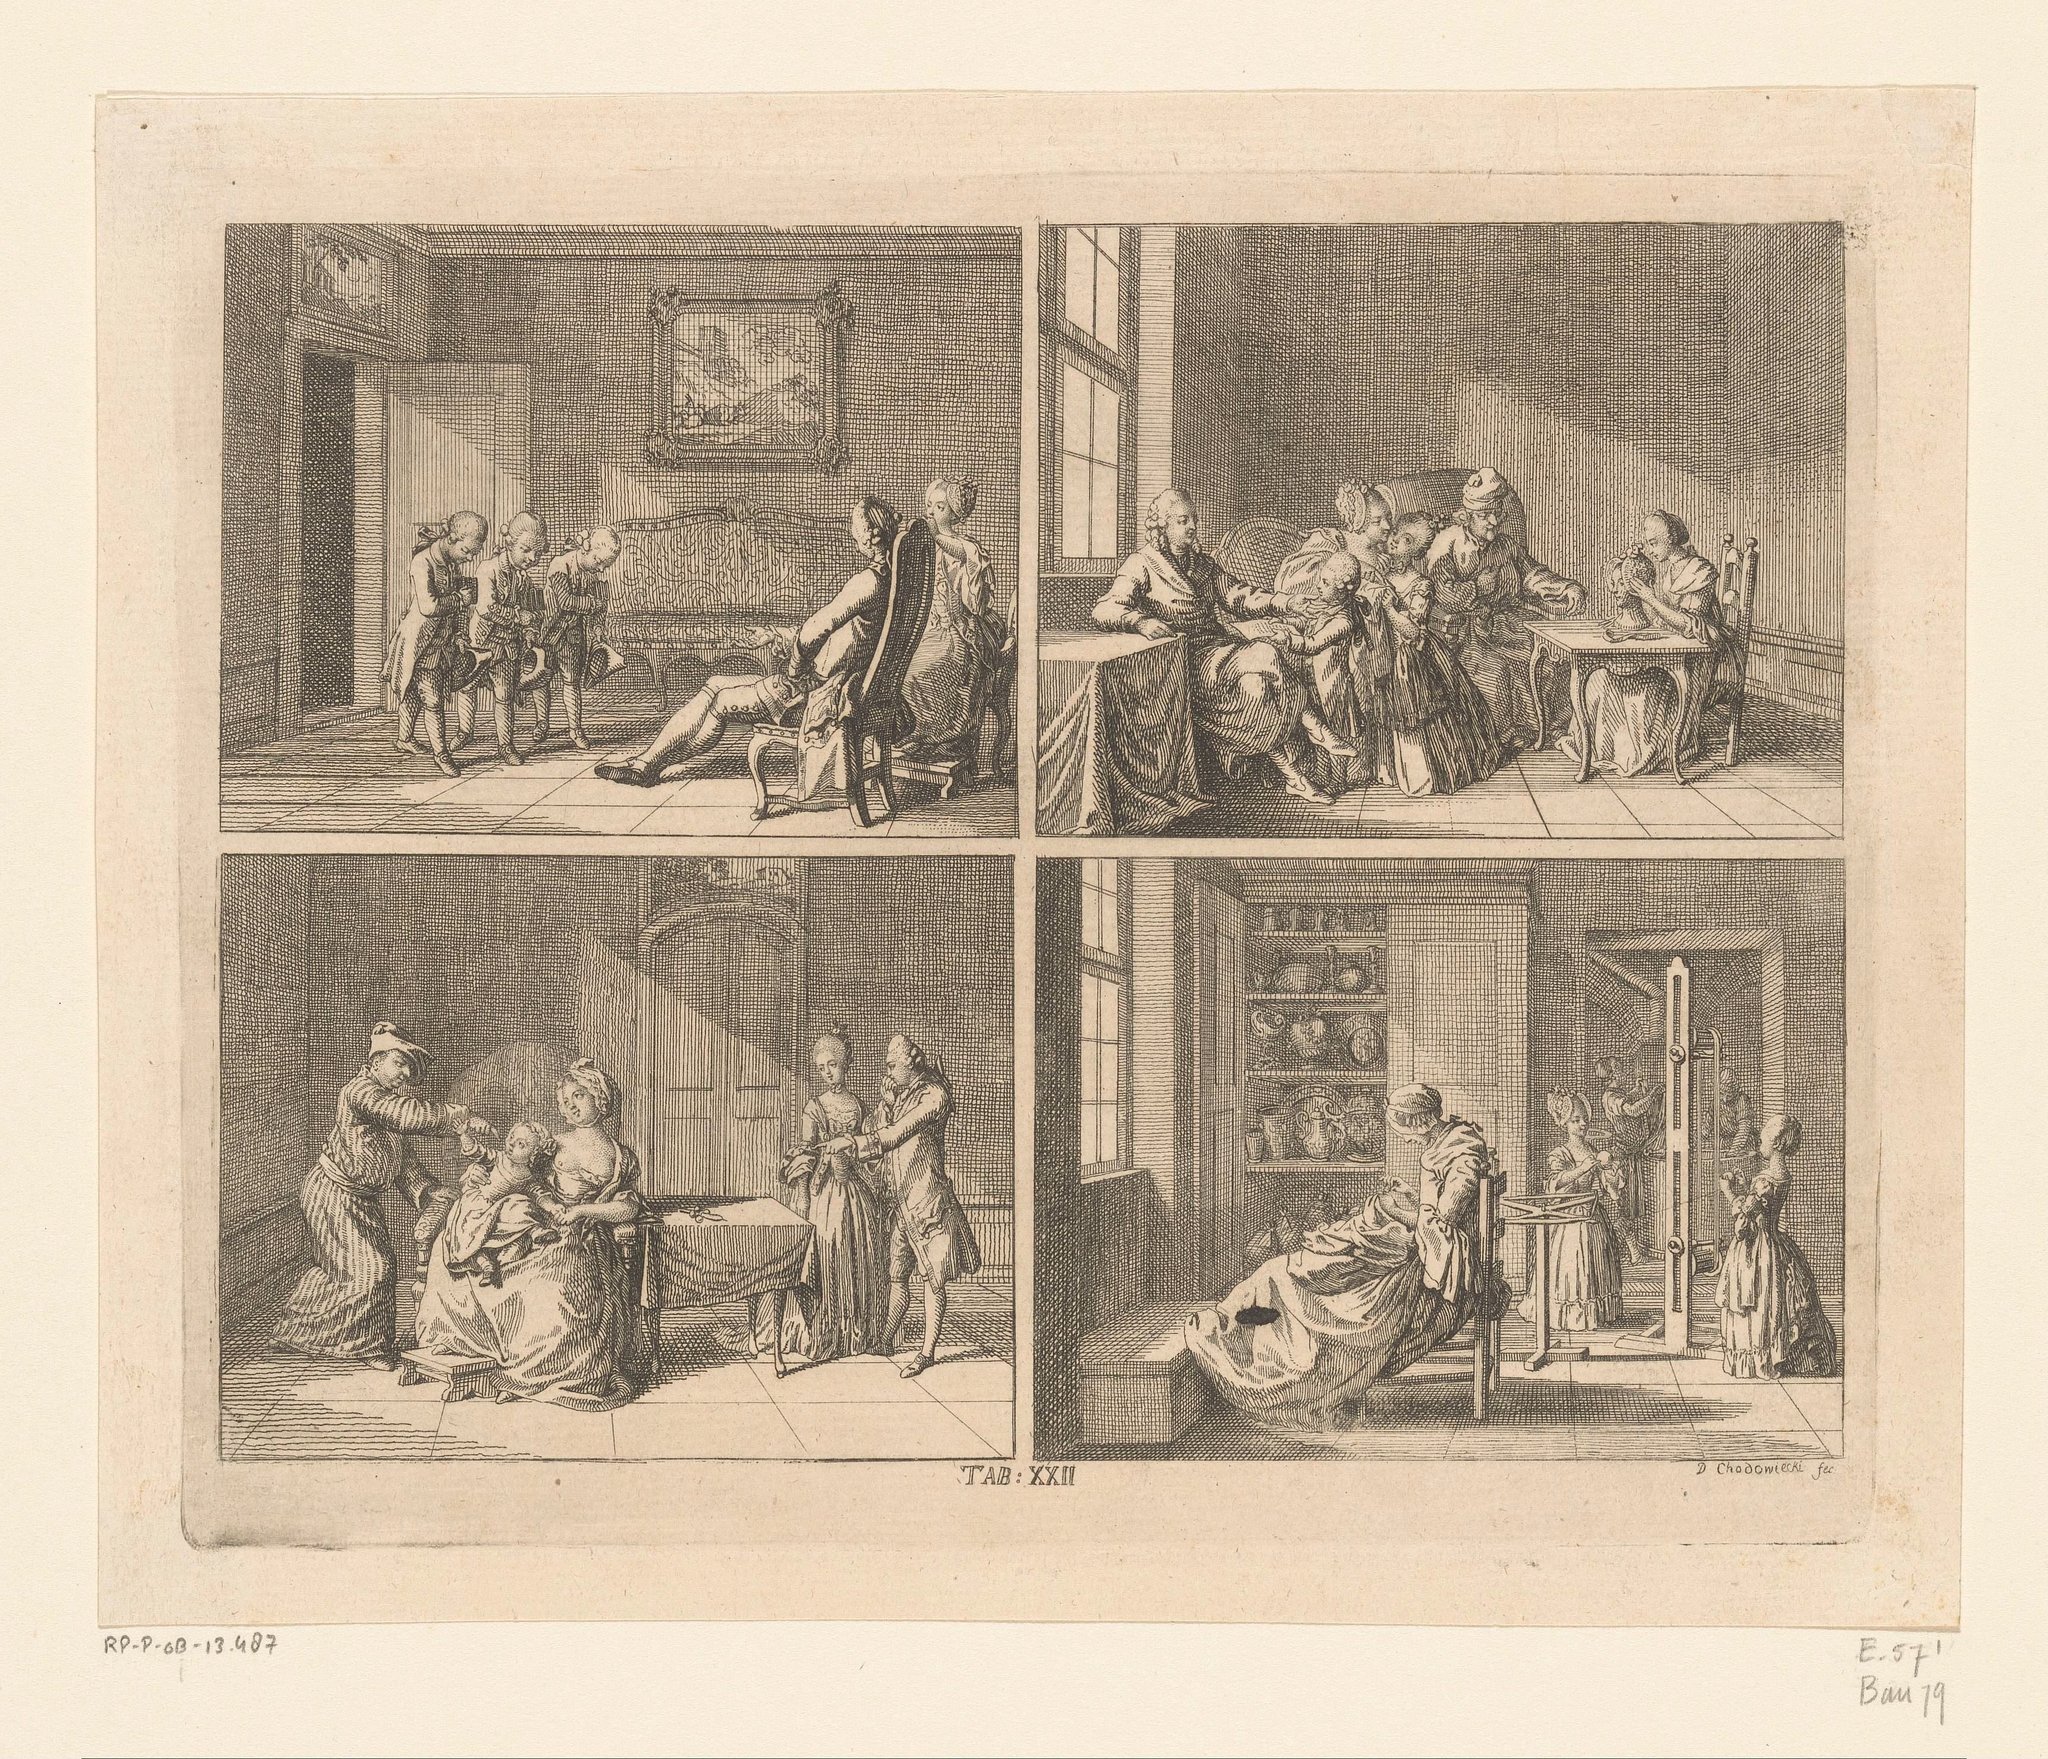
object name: print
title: Menselijke karaktertrekken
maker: daniel nikolaus chodowiecki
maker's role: draughtsman, print maker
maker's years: 1726-1801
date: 1769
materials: paper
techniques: etching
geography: berlin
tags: johann bernhard basedow, parents with their children, returning home from school (+ report, mark ~ school), head bent forward; bowing, home sewing; repair of clothes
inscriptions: collector's mark: Lugt 2228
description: Vier scènes die menselijke karaktertrekken verbeelden. Boven drie jongens die buigen voor hun ouders (voorbeeld van dankbaarheid) en kinderen die hun rapportcijfers laten zien (voorbeeld van succes). Onder ouders met een kind (voorbeeld van een gelukkig huwelijk) en een interieur met een handwerkende vrouw en kinderen die bezig zijn met het wikkelen van garen (voorbeeld van het leven in welstand). Middenonder genummerd: Tab. XXII.